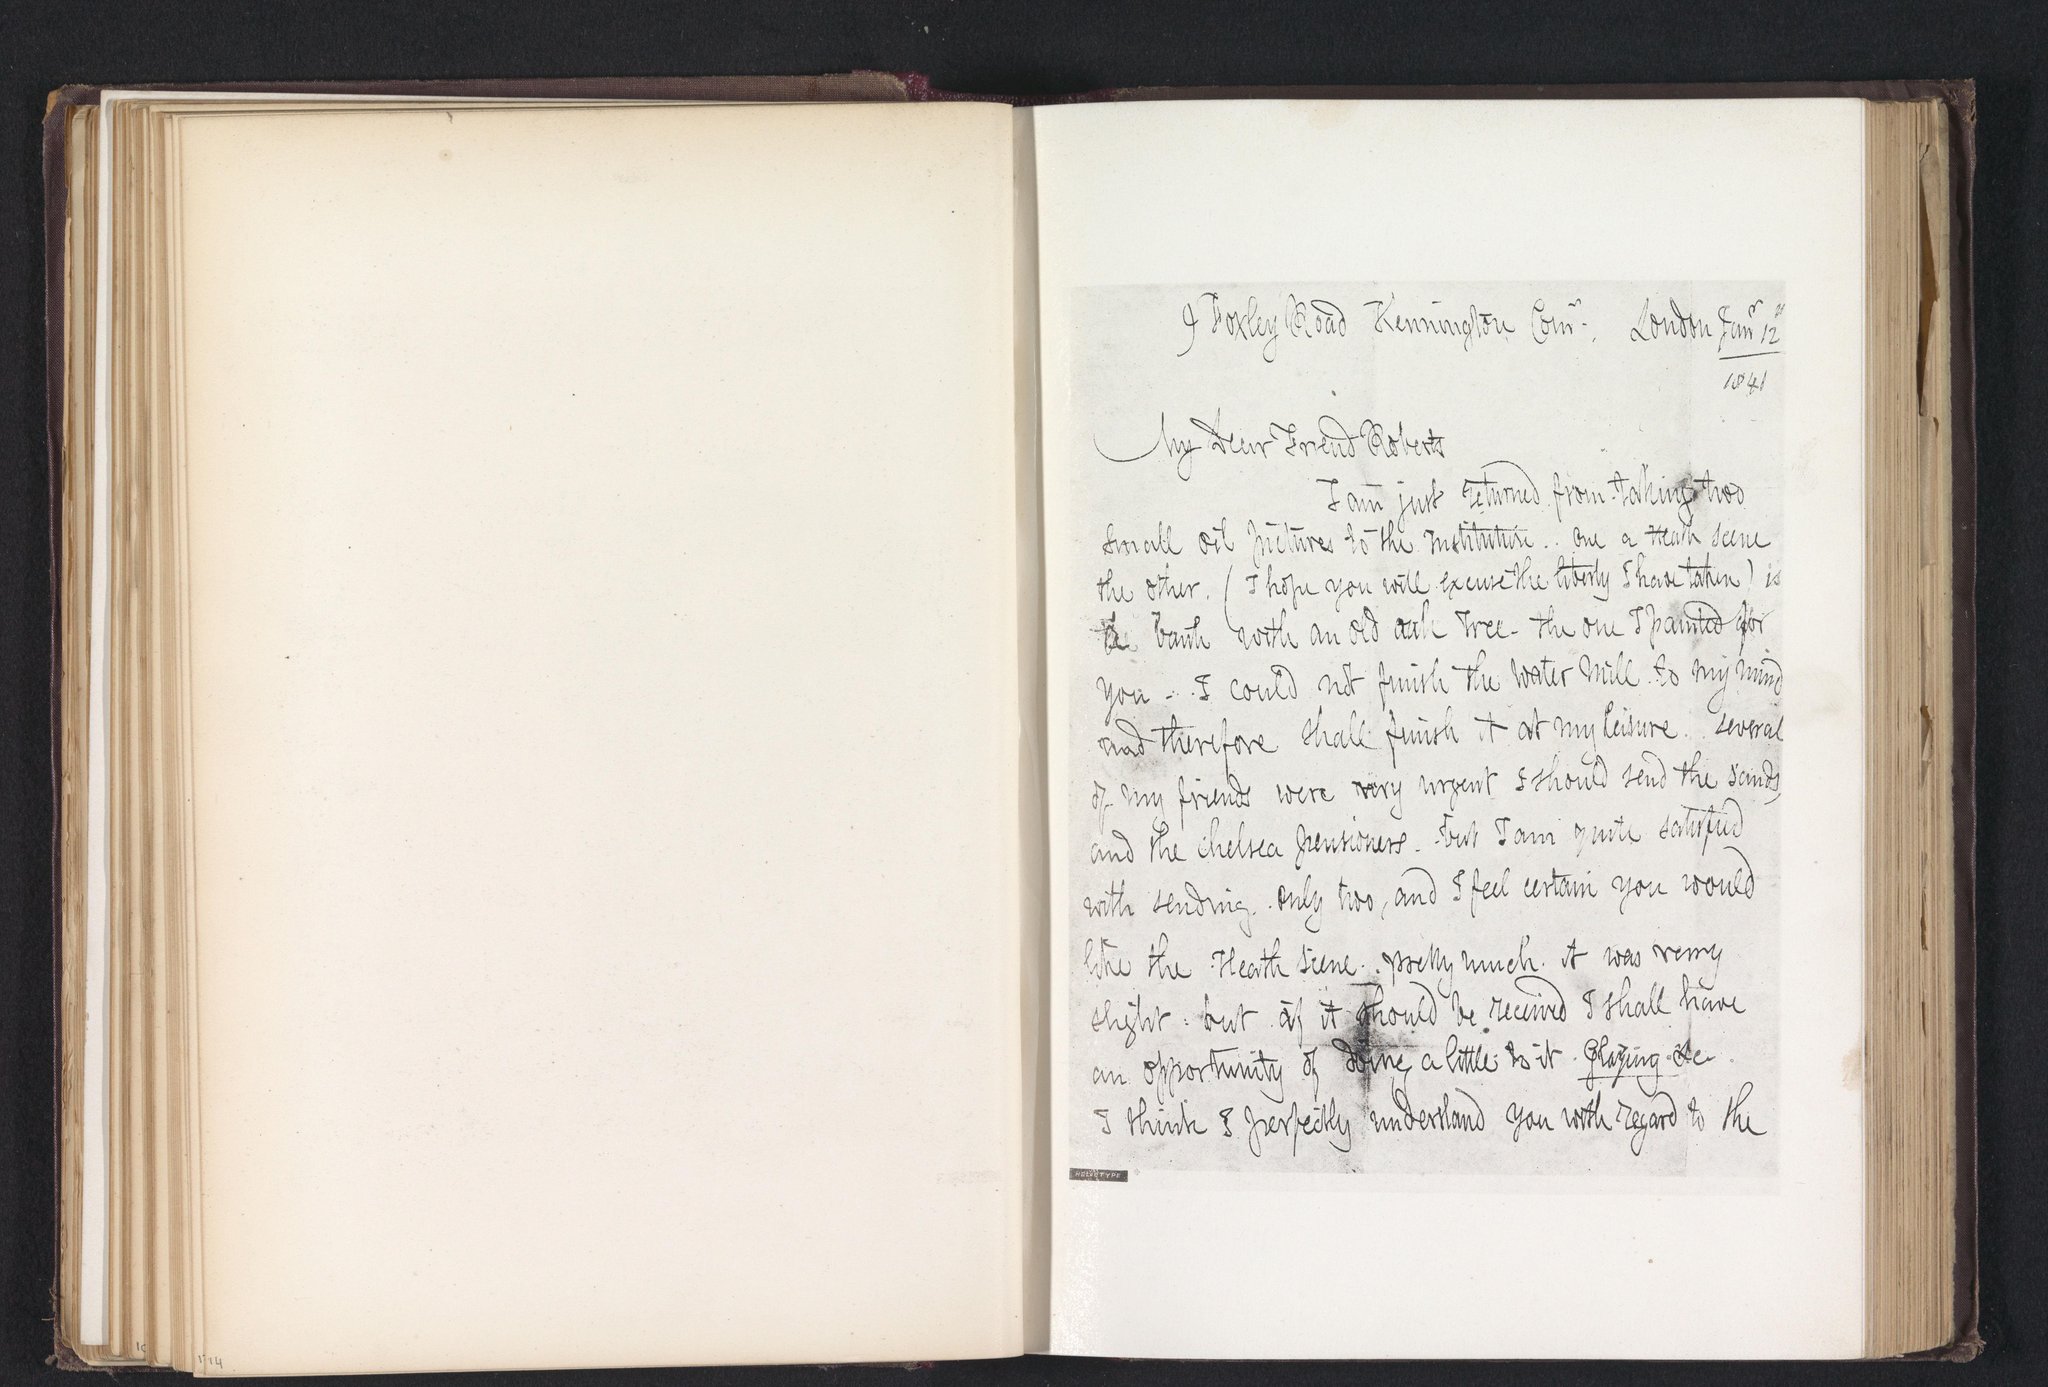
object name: photomechanical print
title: Fotoreproductie van een brief van David Cox aan William Roberts op 12 januari van 1841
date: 1863-1873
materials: paper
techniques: photoaquatint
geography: london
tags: letter, envelope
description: RP-F-2001-7-66-15 tot en met RP-F-2001-7-66-18 vormen vermoedelijk samen een brief.